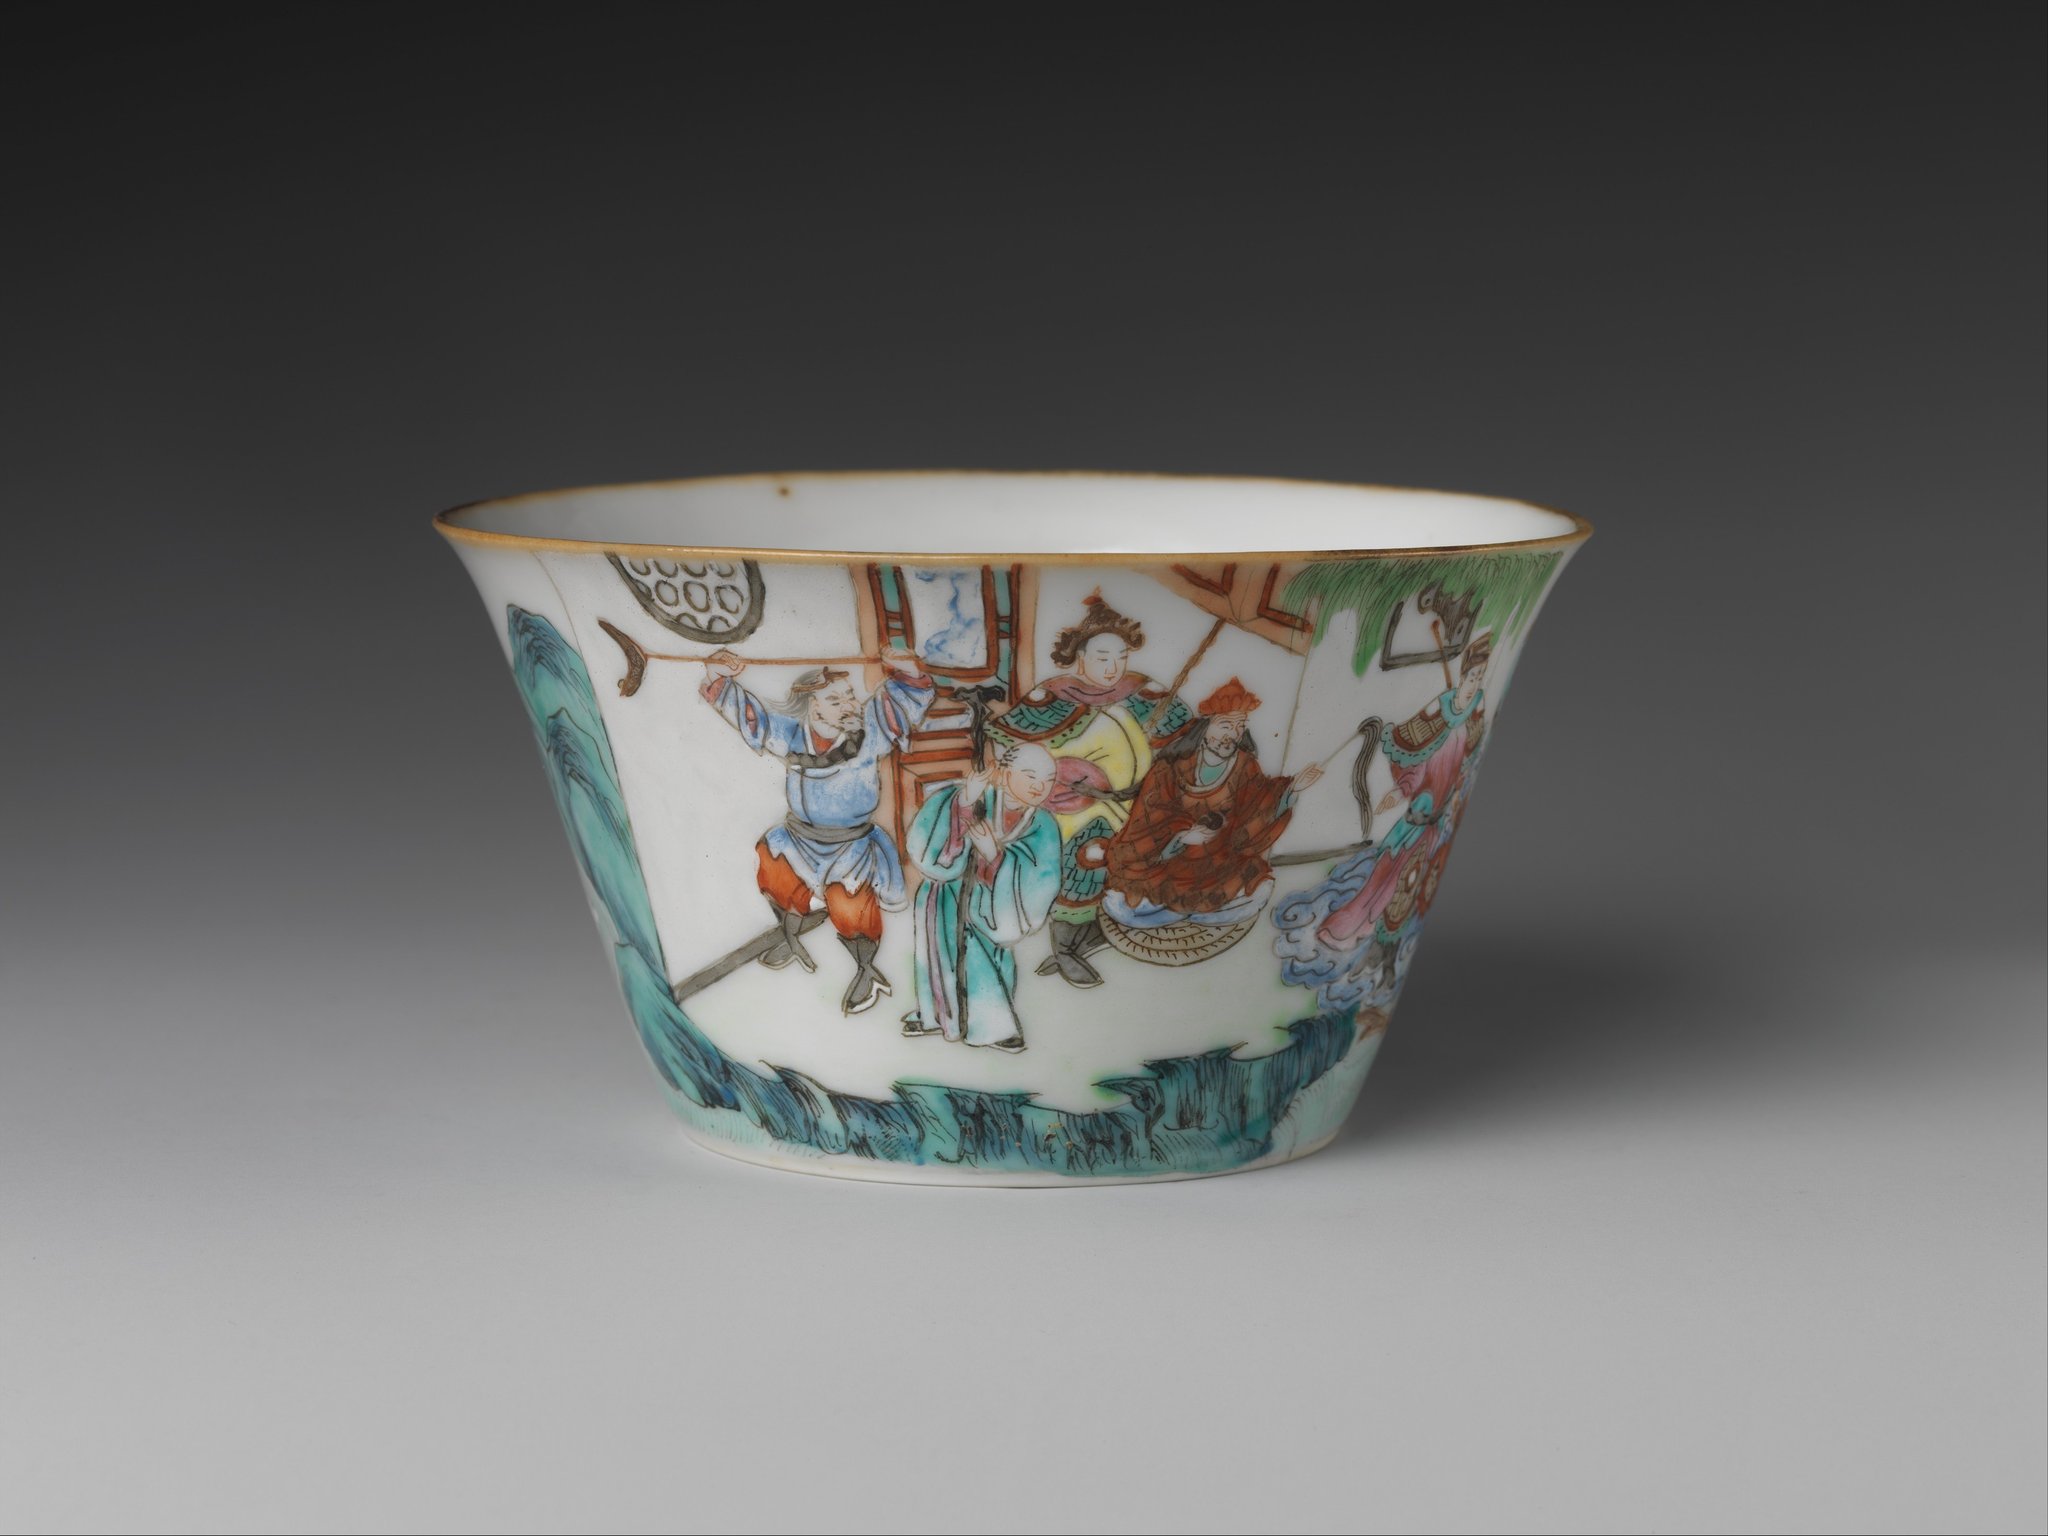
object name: cup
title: Cup with narrative scene from the “Legend of the White Snake”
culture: chinese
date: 1801-1850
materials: enamel, porcelain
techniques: overglaze, painting, polychrome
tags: men